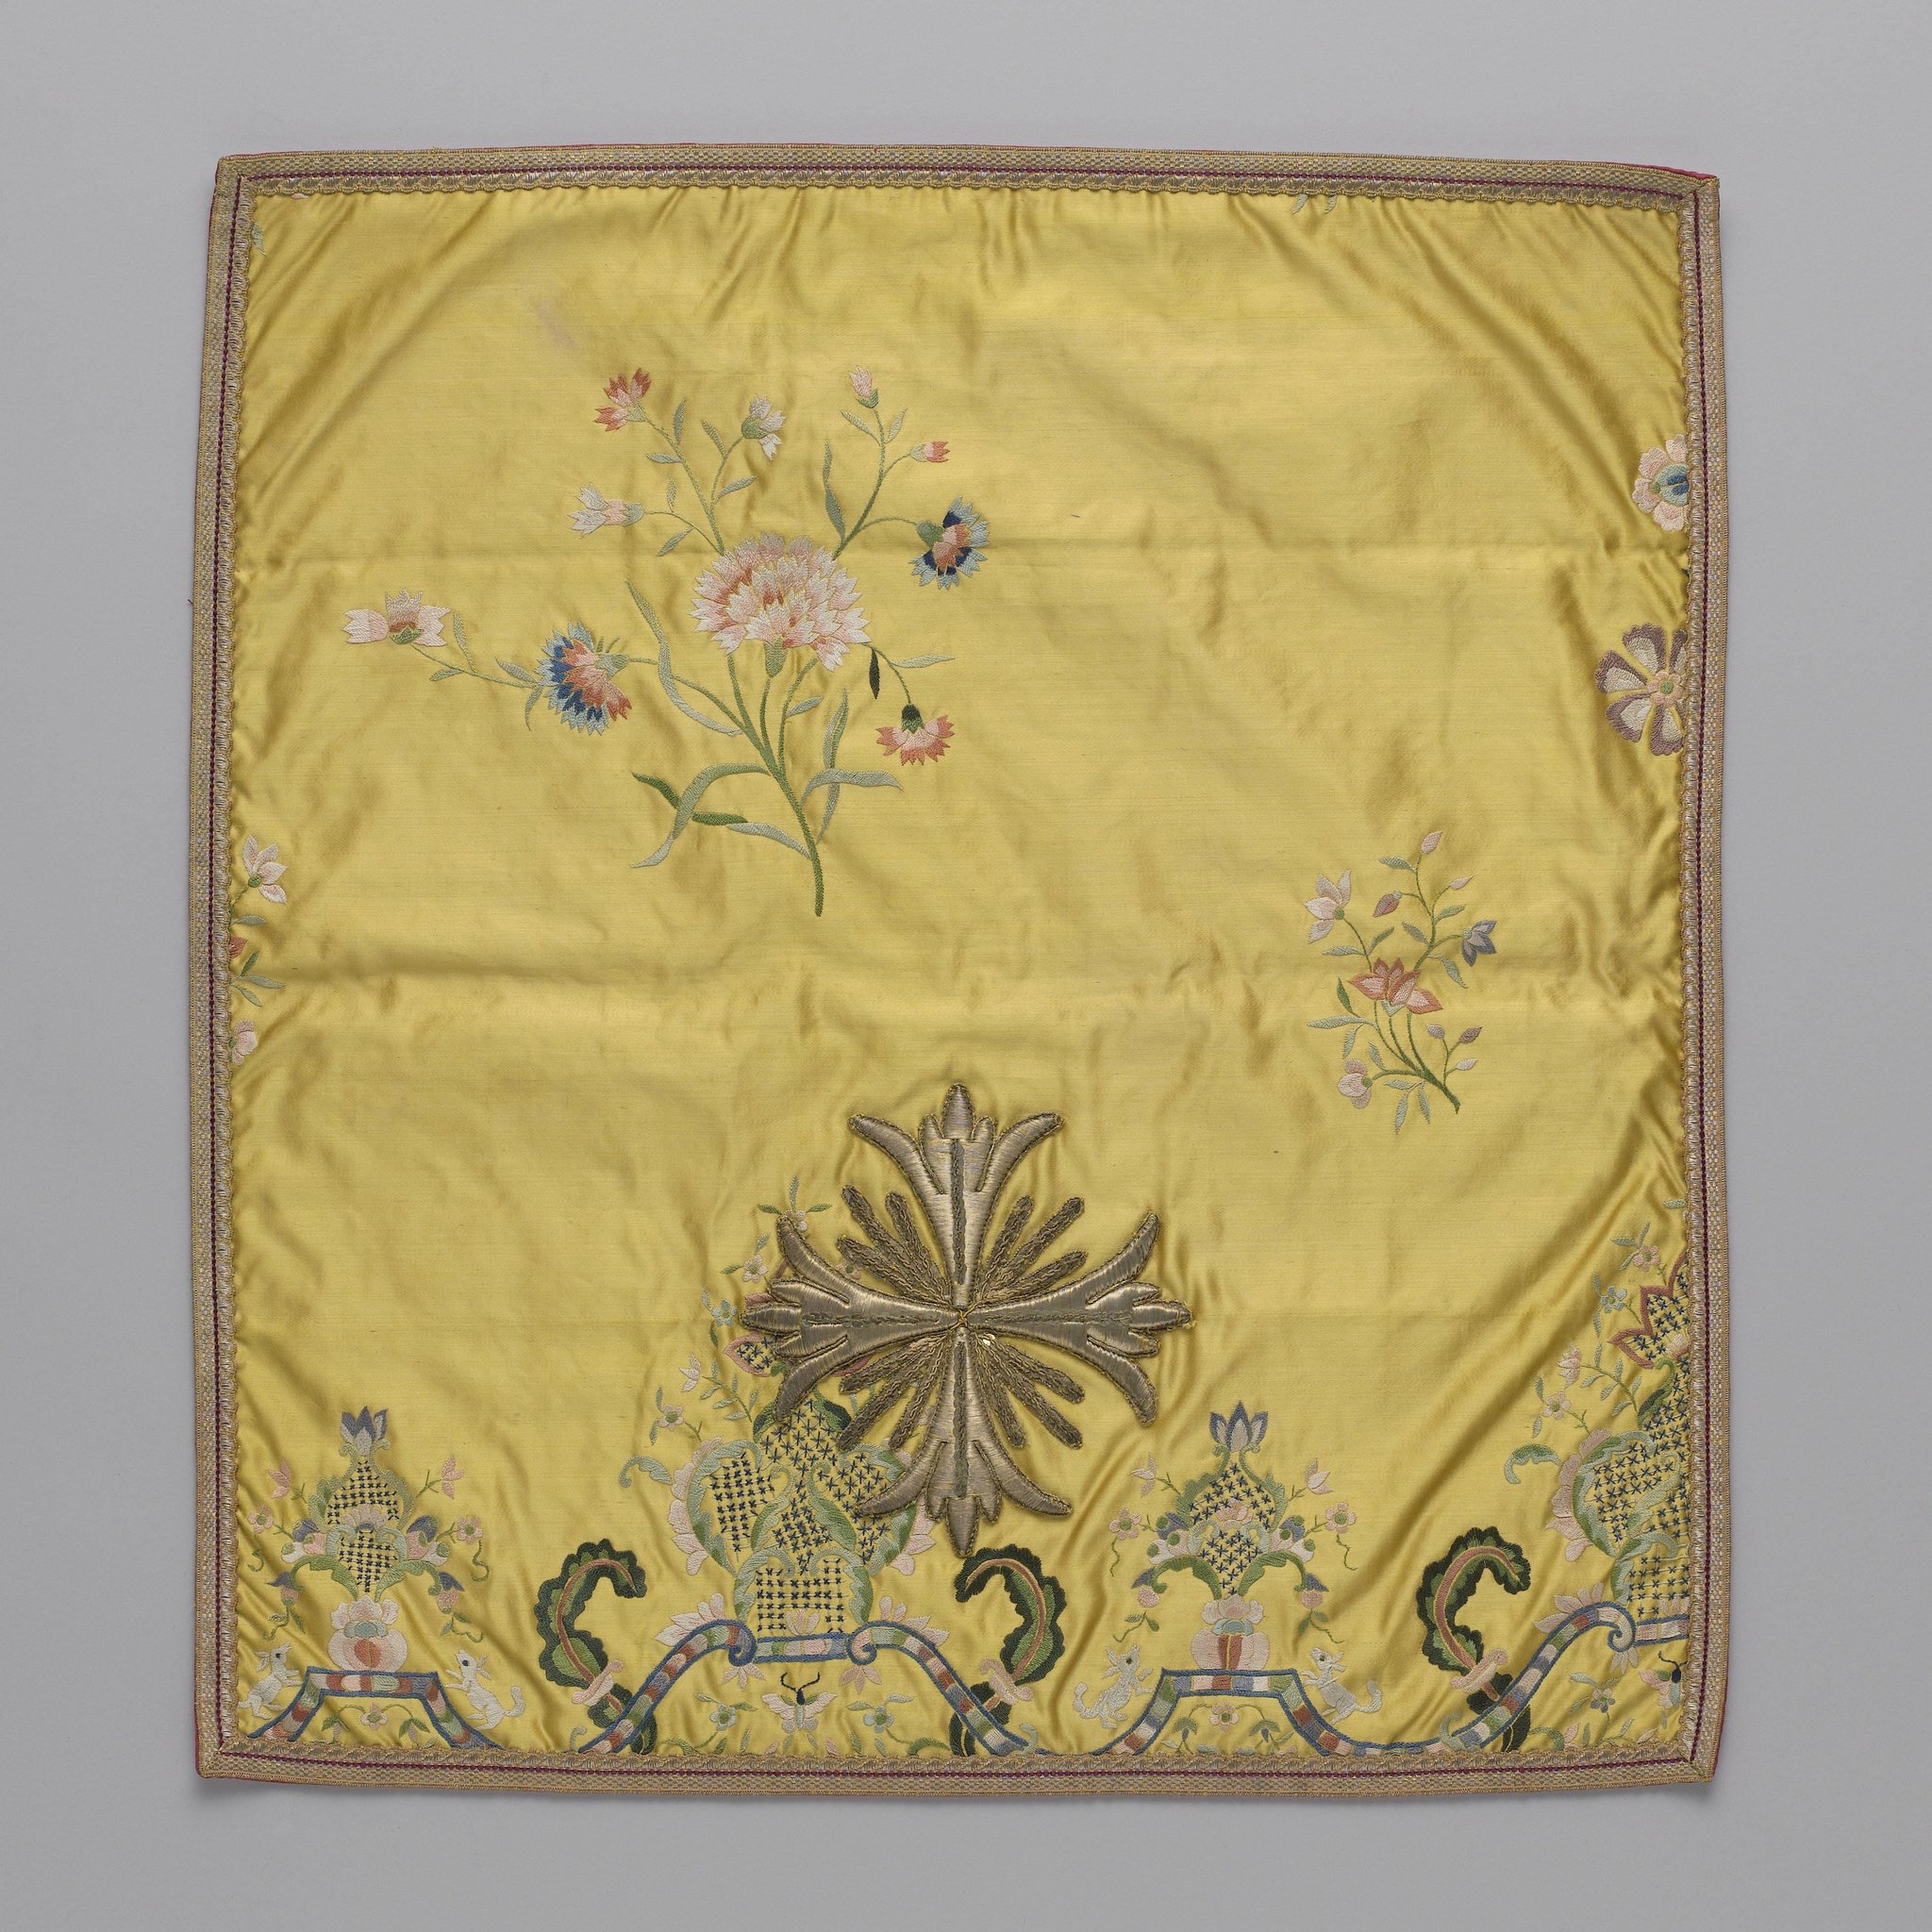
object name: chalice veil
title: Velum van geel zijdesatijn met borduurwerk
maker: Anonymous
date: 1750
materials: gold thread, silk, thread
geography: china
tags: st. franciscus xaveriusparochie ''t zand'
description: Velum van geel zijdesatijn met borduurwerk in zijde en in hoogreliëf met goud- en zilverdraad met voorstelling van Grieks kruis. Velum maakt onderdeel uit van een stel (BK-2008-176-A t/m E).